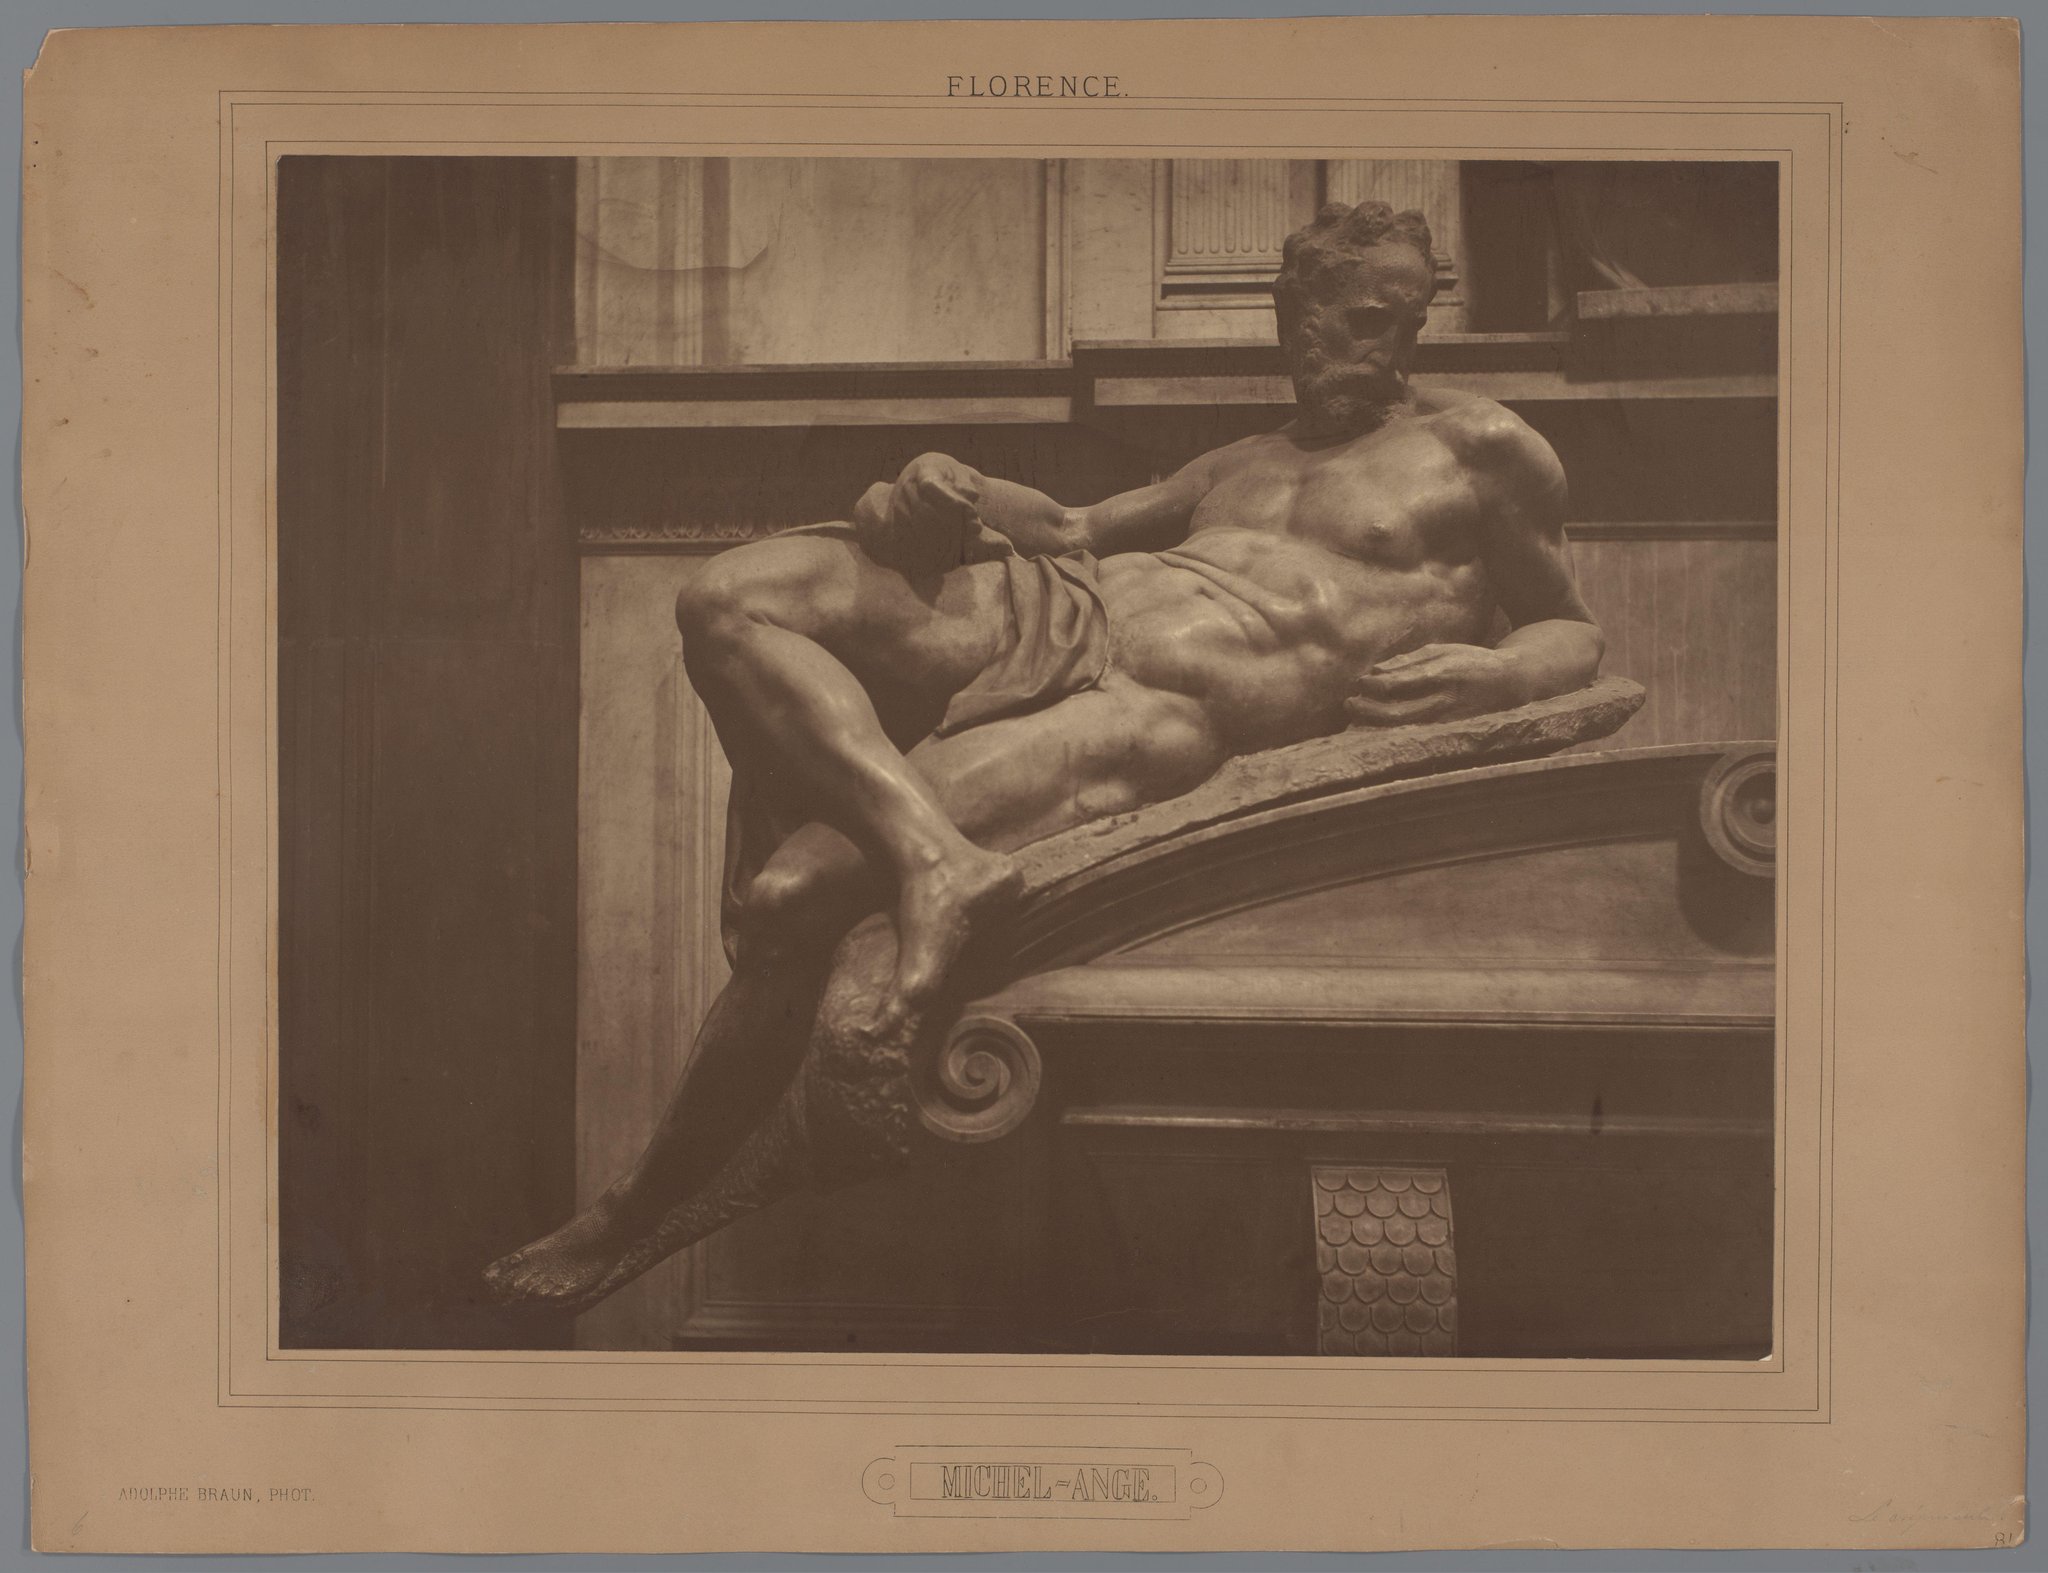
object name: photograph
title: Detail van Leonardo da Vinci's grafmonument voor Lorenzo de' Medici in de San Lorenzo, Florence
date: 1880-1900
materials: cardboard, paper, photographic support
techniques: carbon print